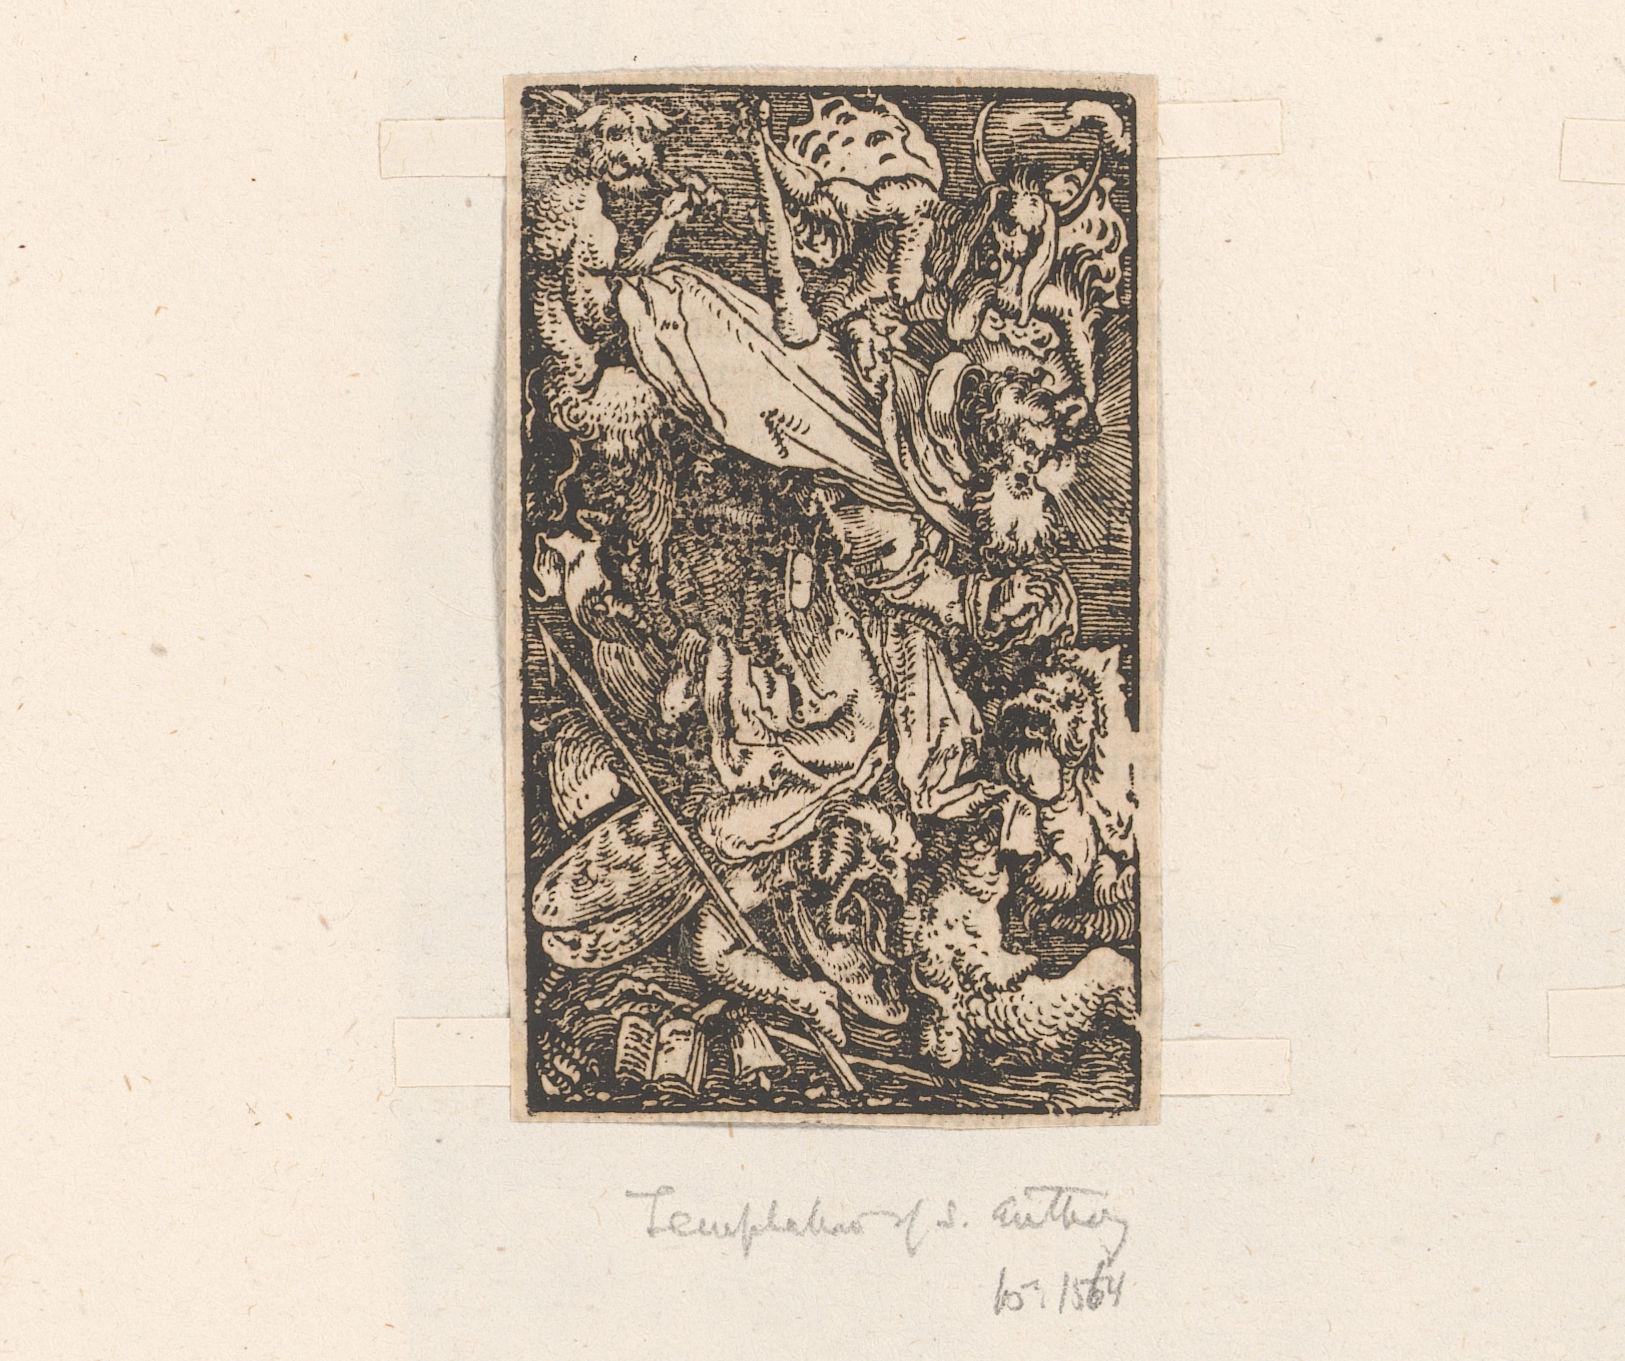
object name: book illustration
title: Verzoeking van Antonius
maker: Anonymous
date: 1500-1536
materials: paper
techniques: letterpress printing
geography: germany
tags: st. antony abbot tormented by devils, attacking him on the ground or carrying him aloft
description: De Heilige Antonius Abt wordt gekweld door duivels. Prent maakt deel uit van een album.